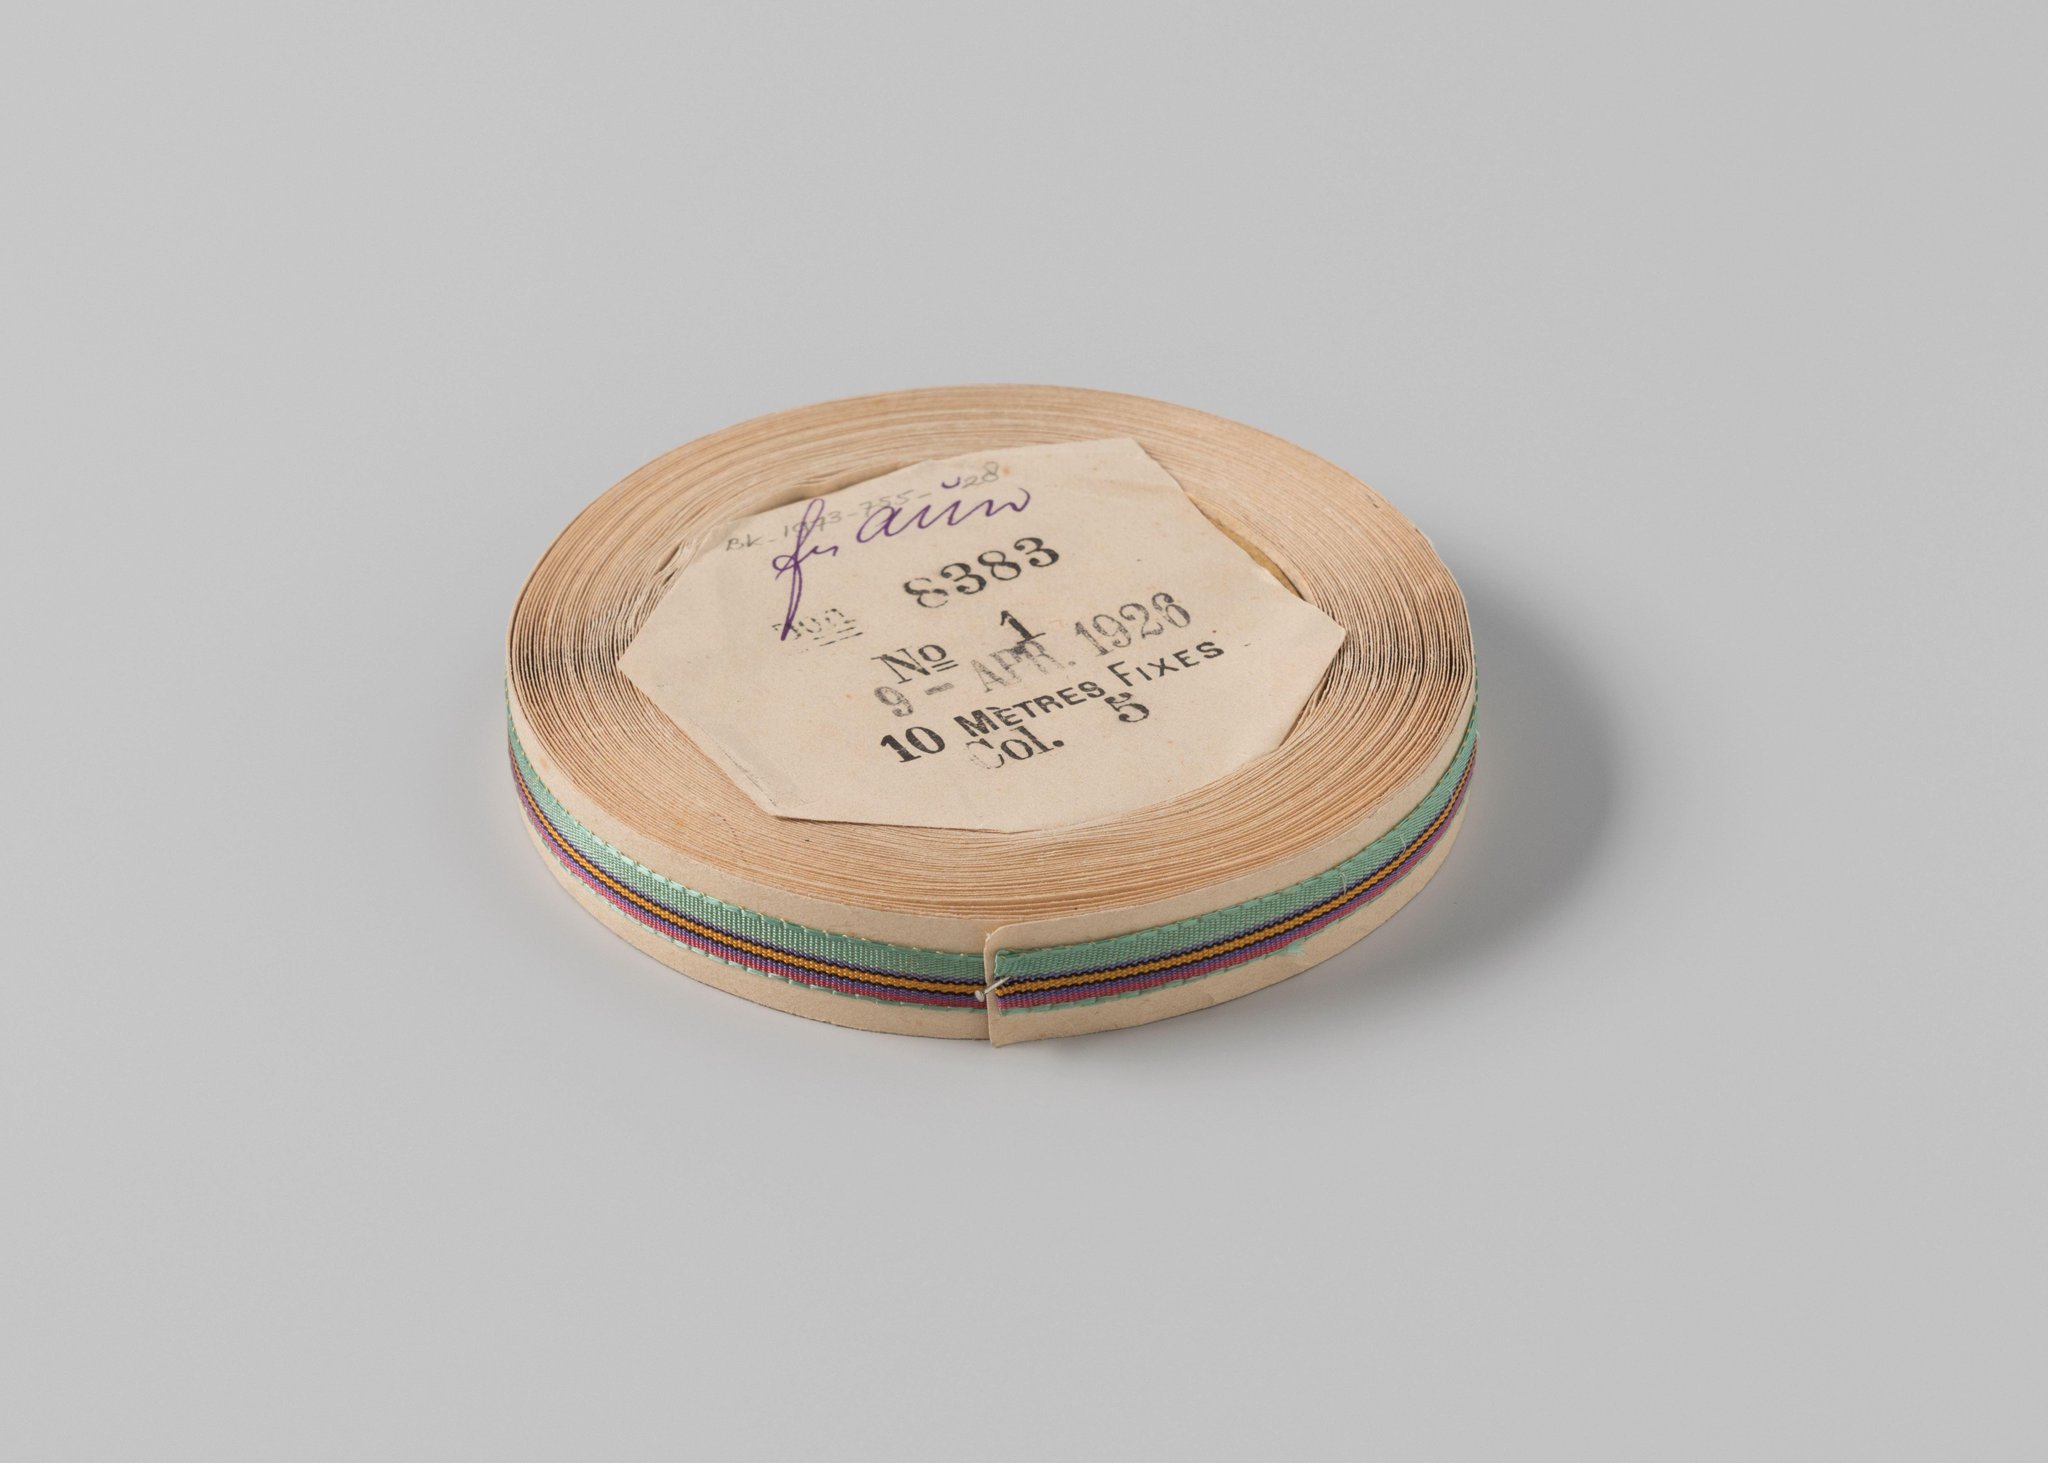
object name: ribbon material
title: Lint op rol, gestreept, groen met magenta, zwart, grijs en oranje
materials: cardboard, paper, textile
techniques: weave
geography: france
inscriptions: number: ‘Pon 8383’, stamp: ‘9 - APR. 1926’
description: Lint op rol, gestreept, groen met magenta, zwart, grijs en oranje.